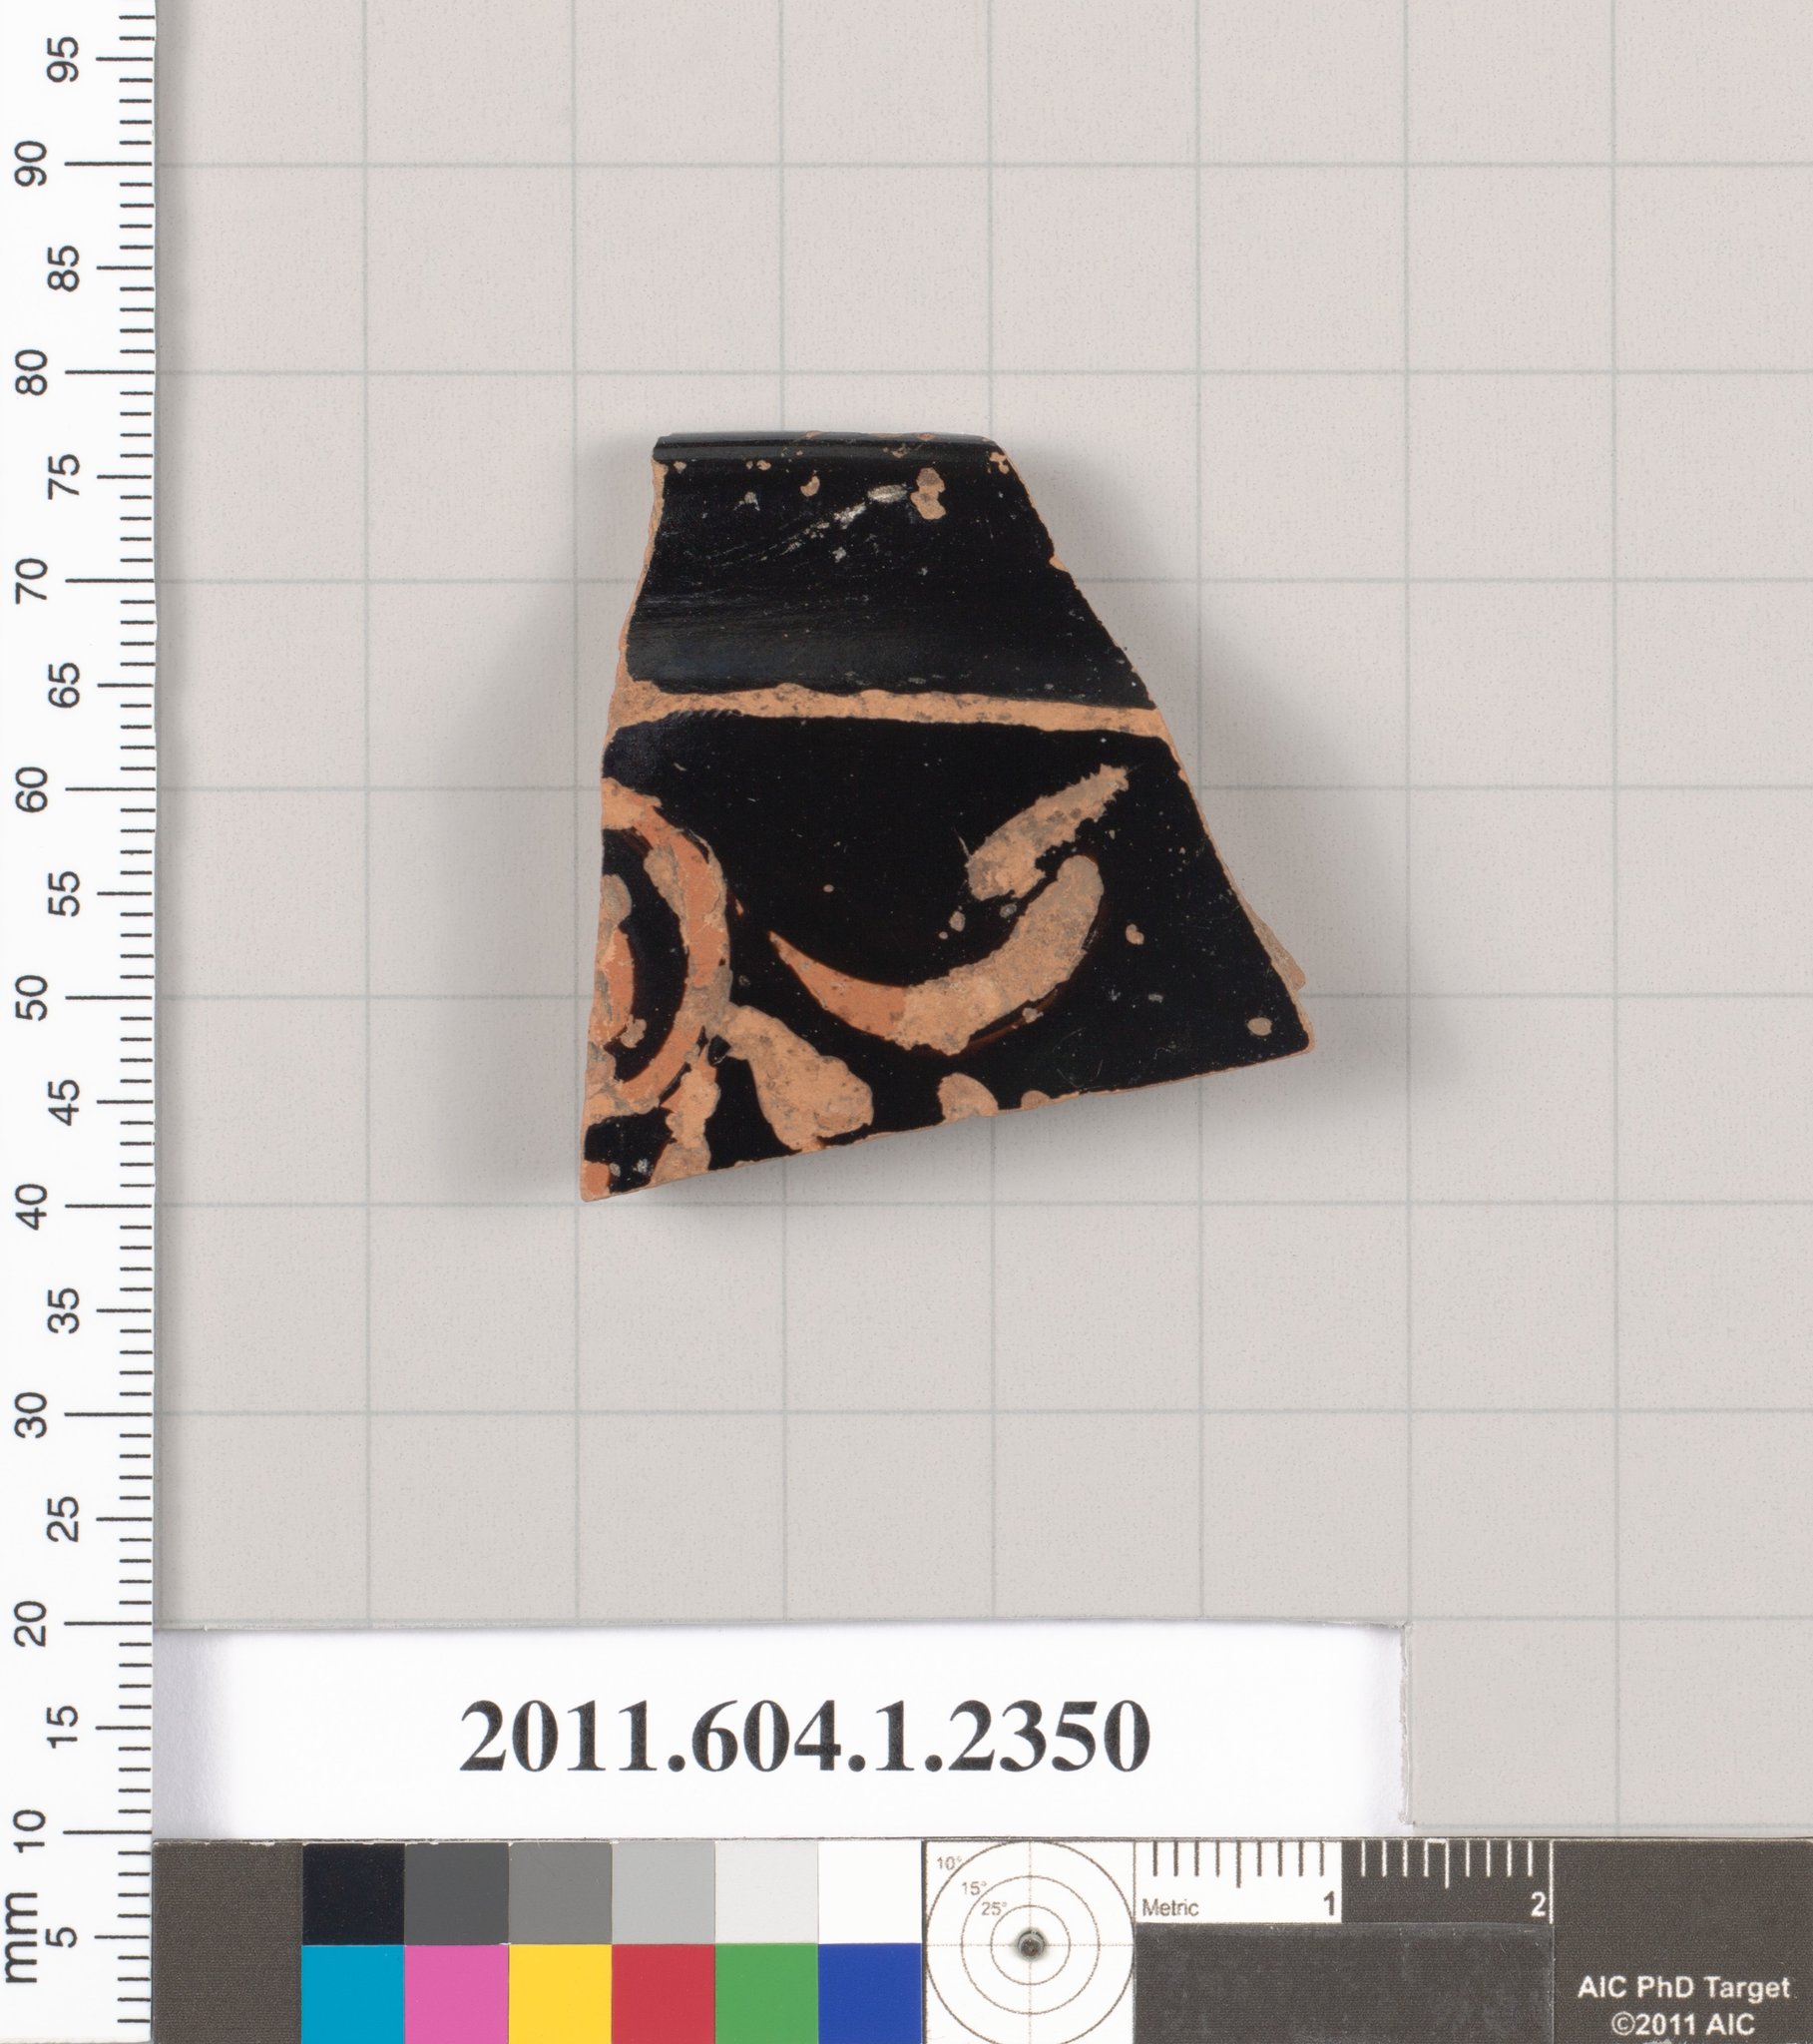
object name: kylix fragment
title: Terracotta rim fragment of a kylix (drinking cup)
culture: greek, attic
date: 467-435 BCE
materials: terracotta